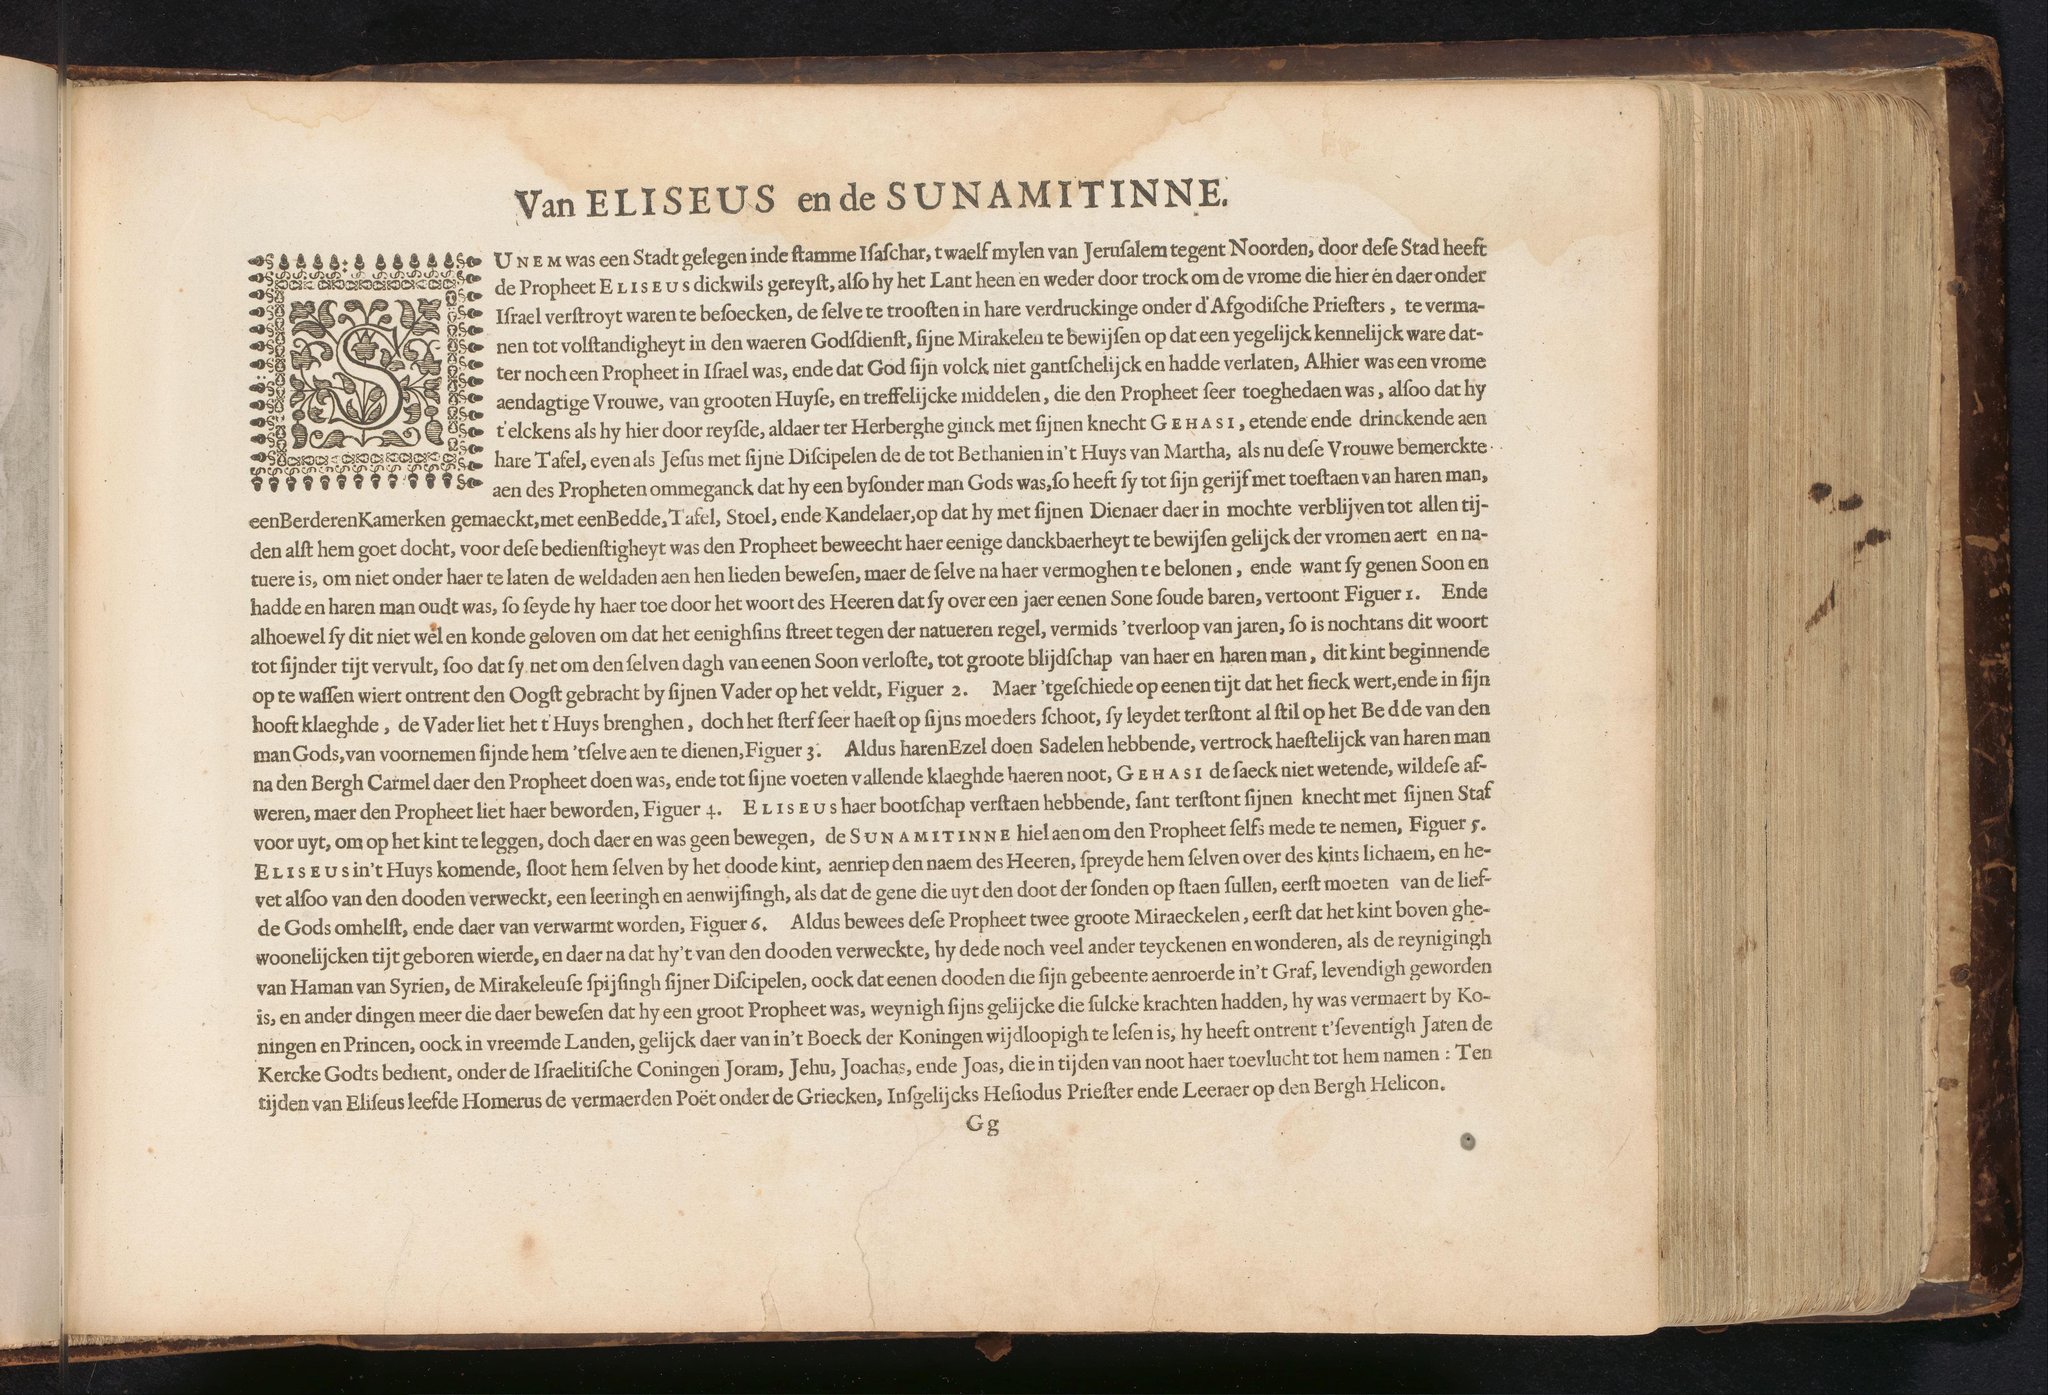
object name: text sheet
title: Van Eliseus en de Sunamitinne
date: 1646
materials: paper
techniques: letterpress printing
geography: alkmaar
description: Tekstblad bij een serie prenten over de geschiedenis van Elisa en de vrouw uit Sunem. Linksboven initiaal S. Dit blad maakt deel uit van een album.